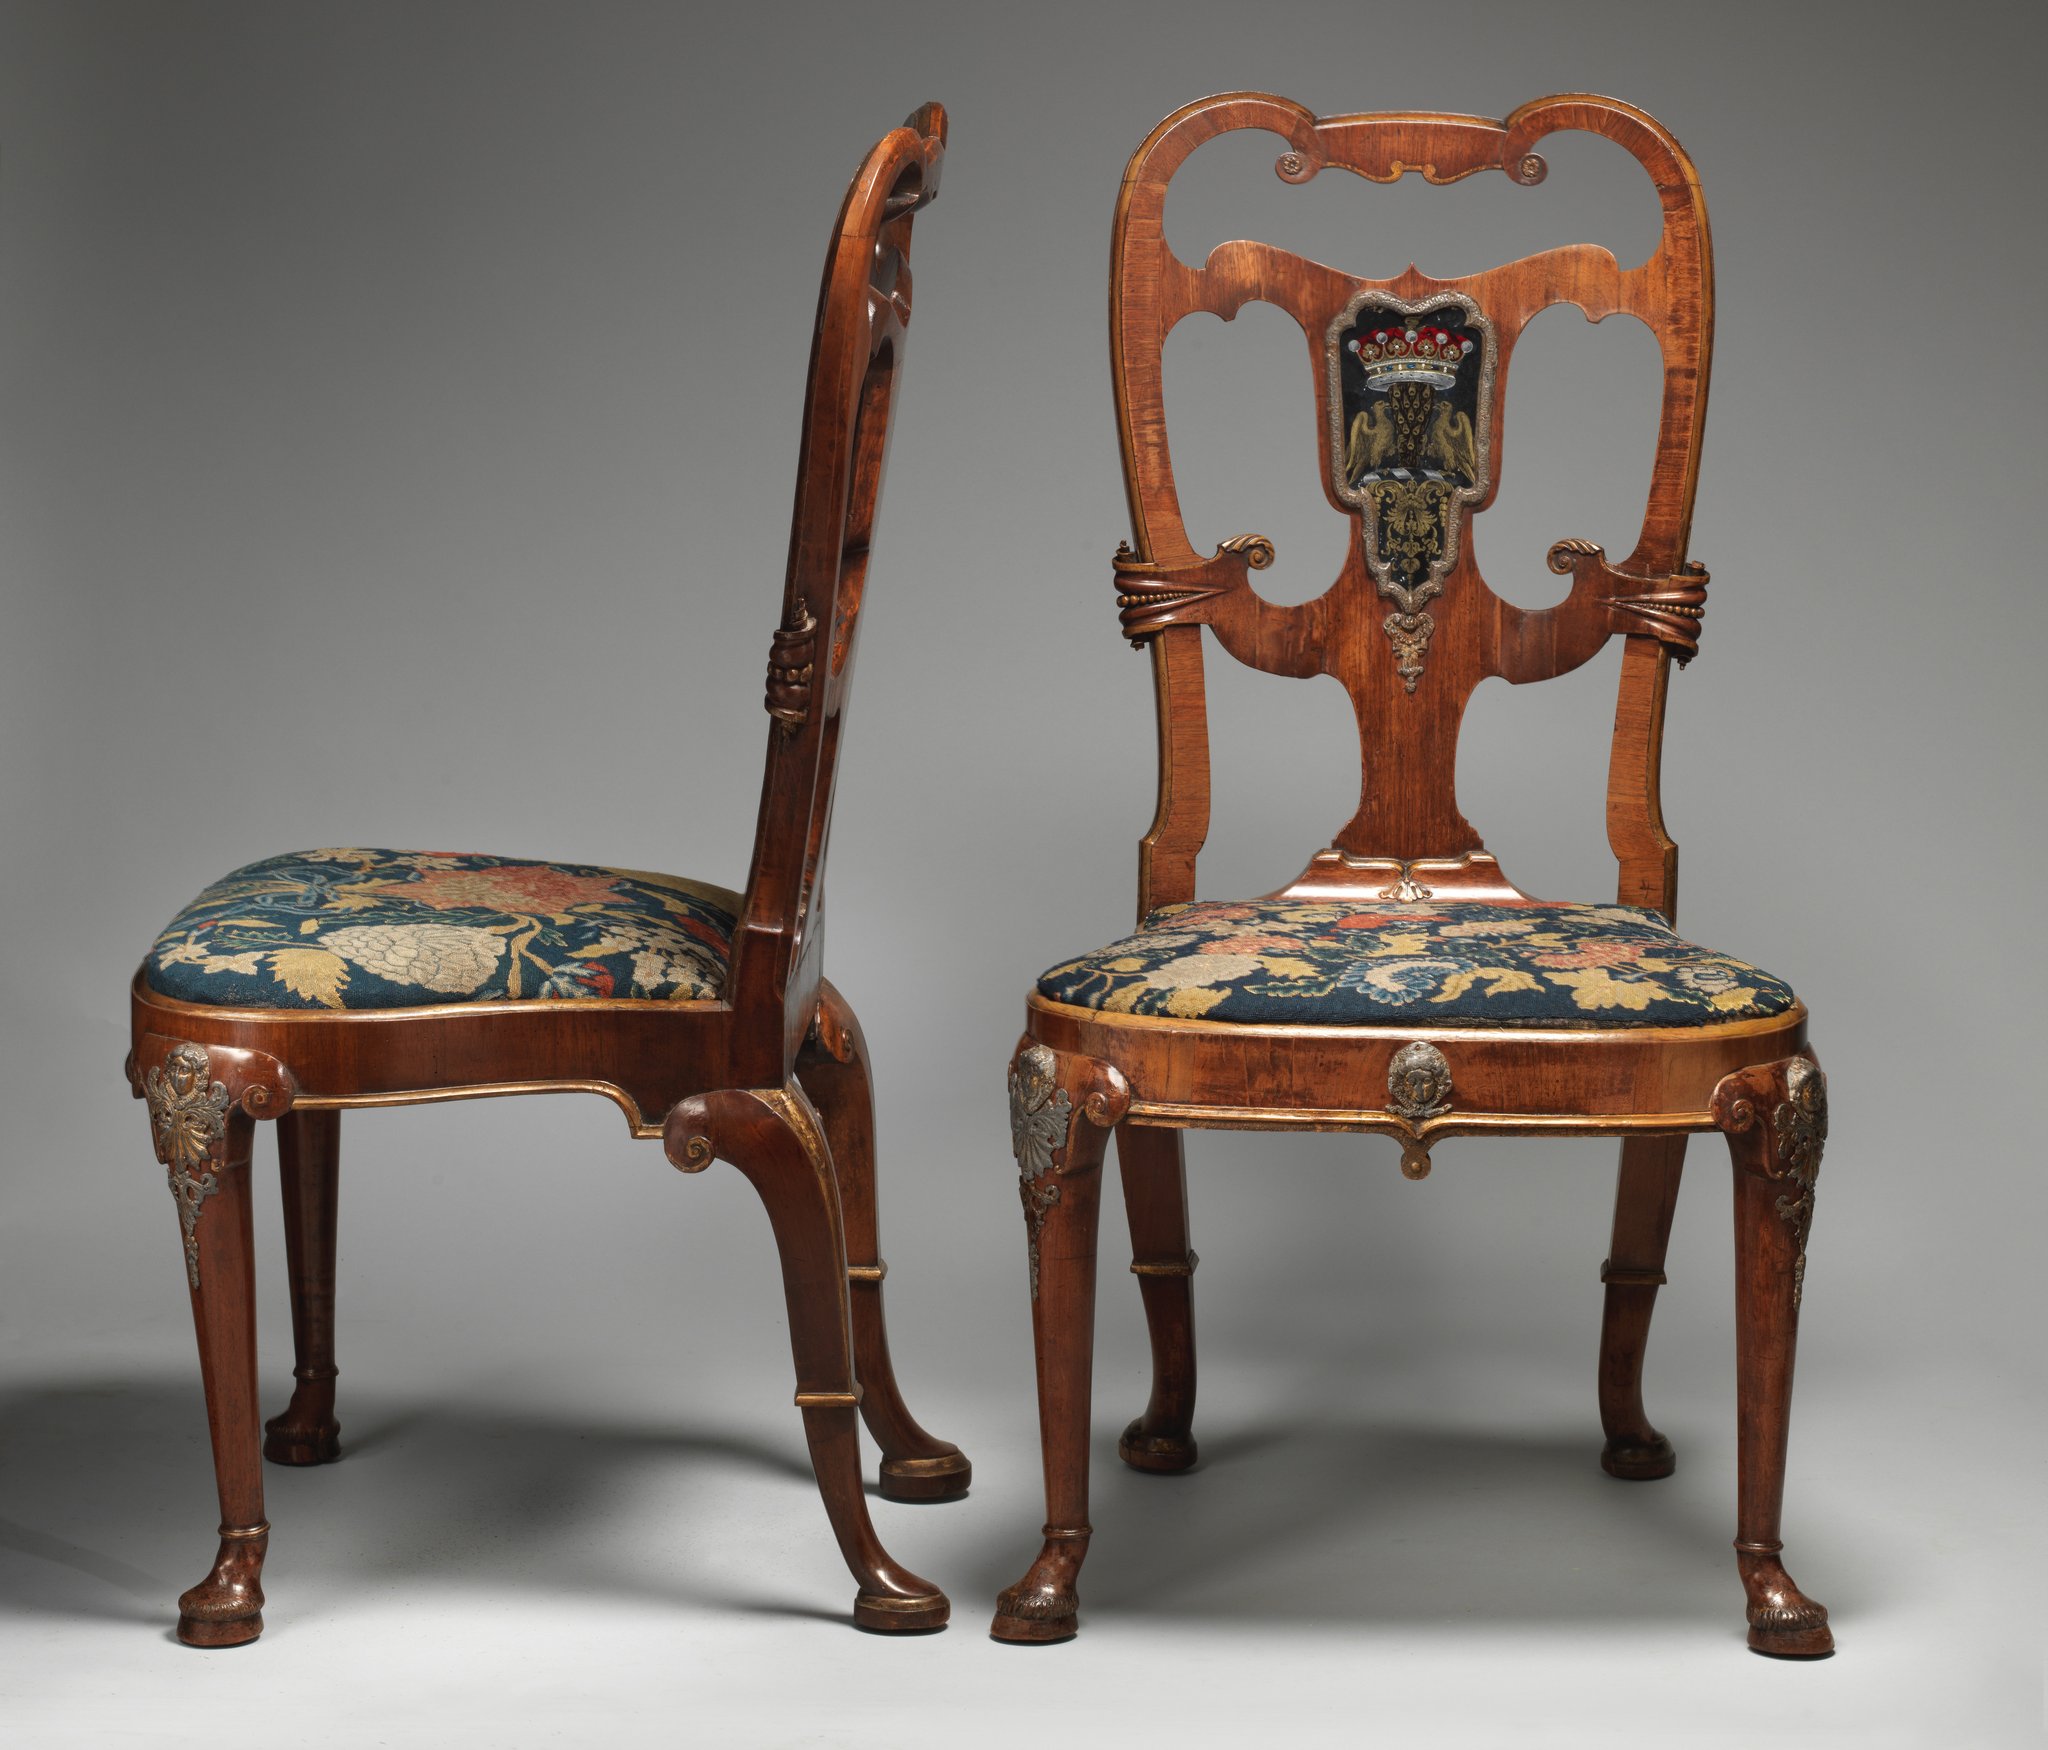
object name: side chair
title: Pair of side chairs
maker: thomas how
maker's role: maker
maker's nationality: british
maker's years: 1710-1733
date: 1724-1736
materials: wood, canvas, gilt, lead, panel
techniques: embroidery, gilding, stitching, veneering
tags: flowers,coat of arms